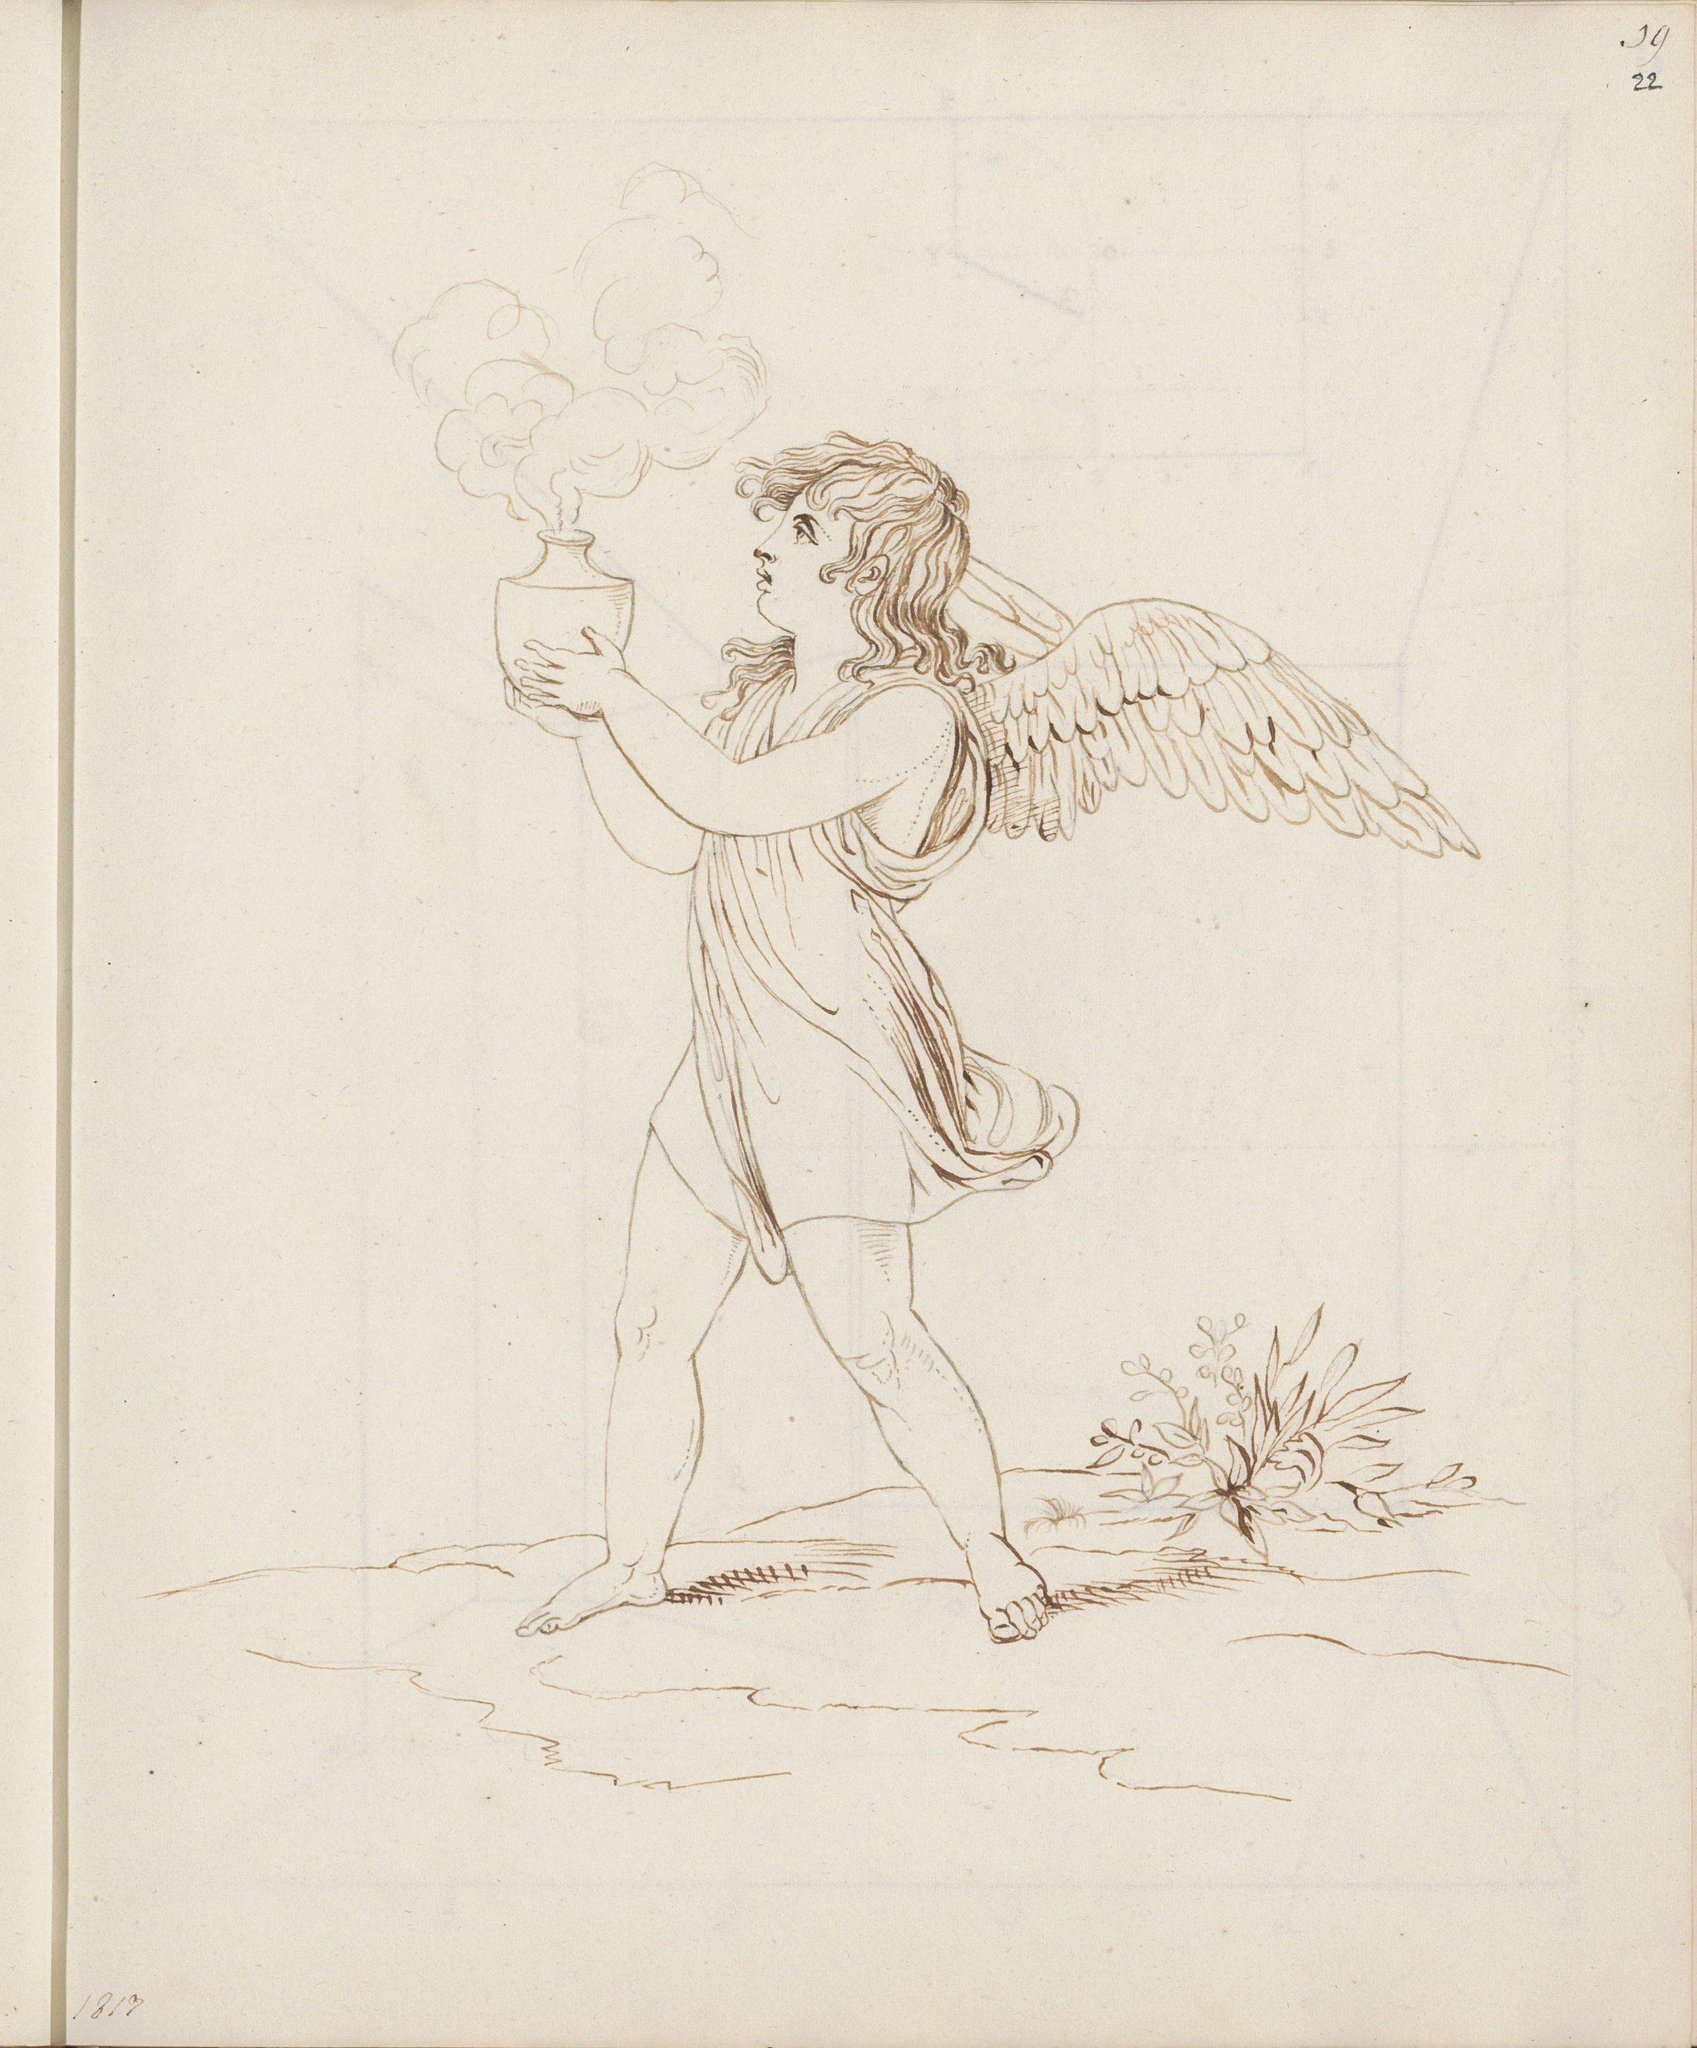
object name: sketchbook leaf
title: Gevleugelde jongen met een rokende urn in een landschap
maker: jonkvrouw elisabeth kemper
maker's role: draughtsman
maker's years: 1799-1871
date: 1817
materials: ink, paper, pencil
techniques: pen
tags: carrying something, angel(s) represented as child(ren)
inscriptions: date: ‘1817’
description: Vermoedelijk naar klassiek voorbeeld. De jongen draagt mogelijk een rookoffer. Blad 22 recto uit een schetsboek met 94 bladen.